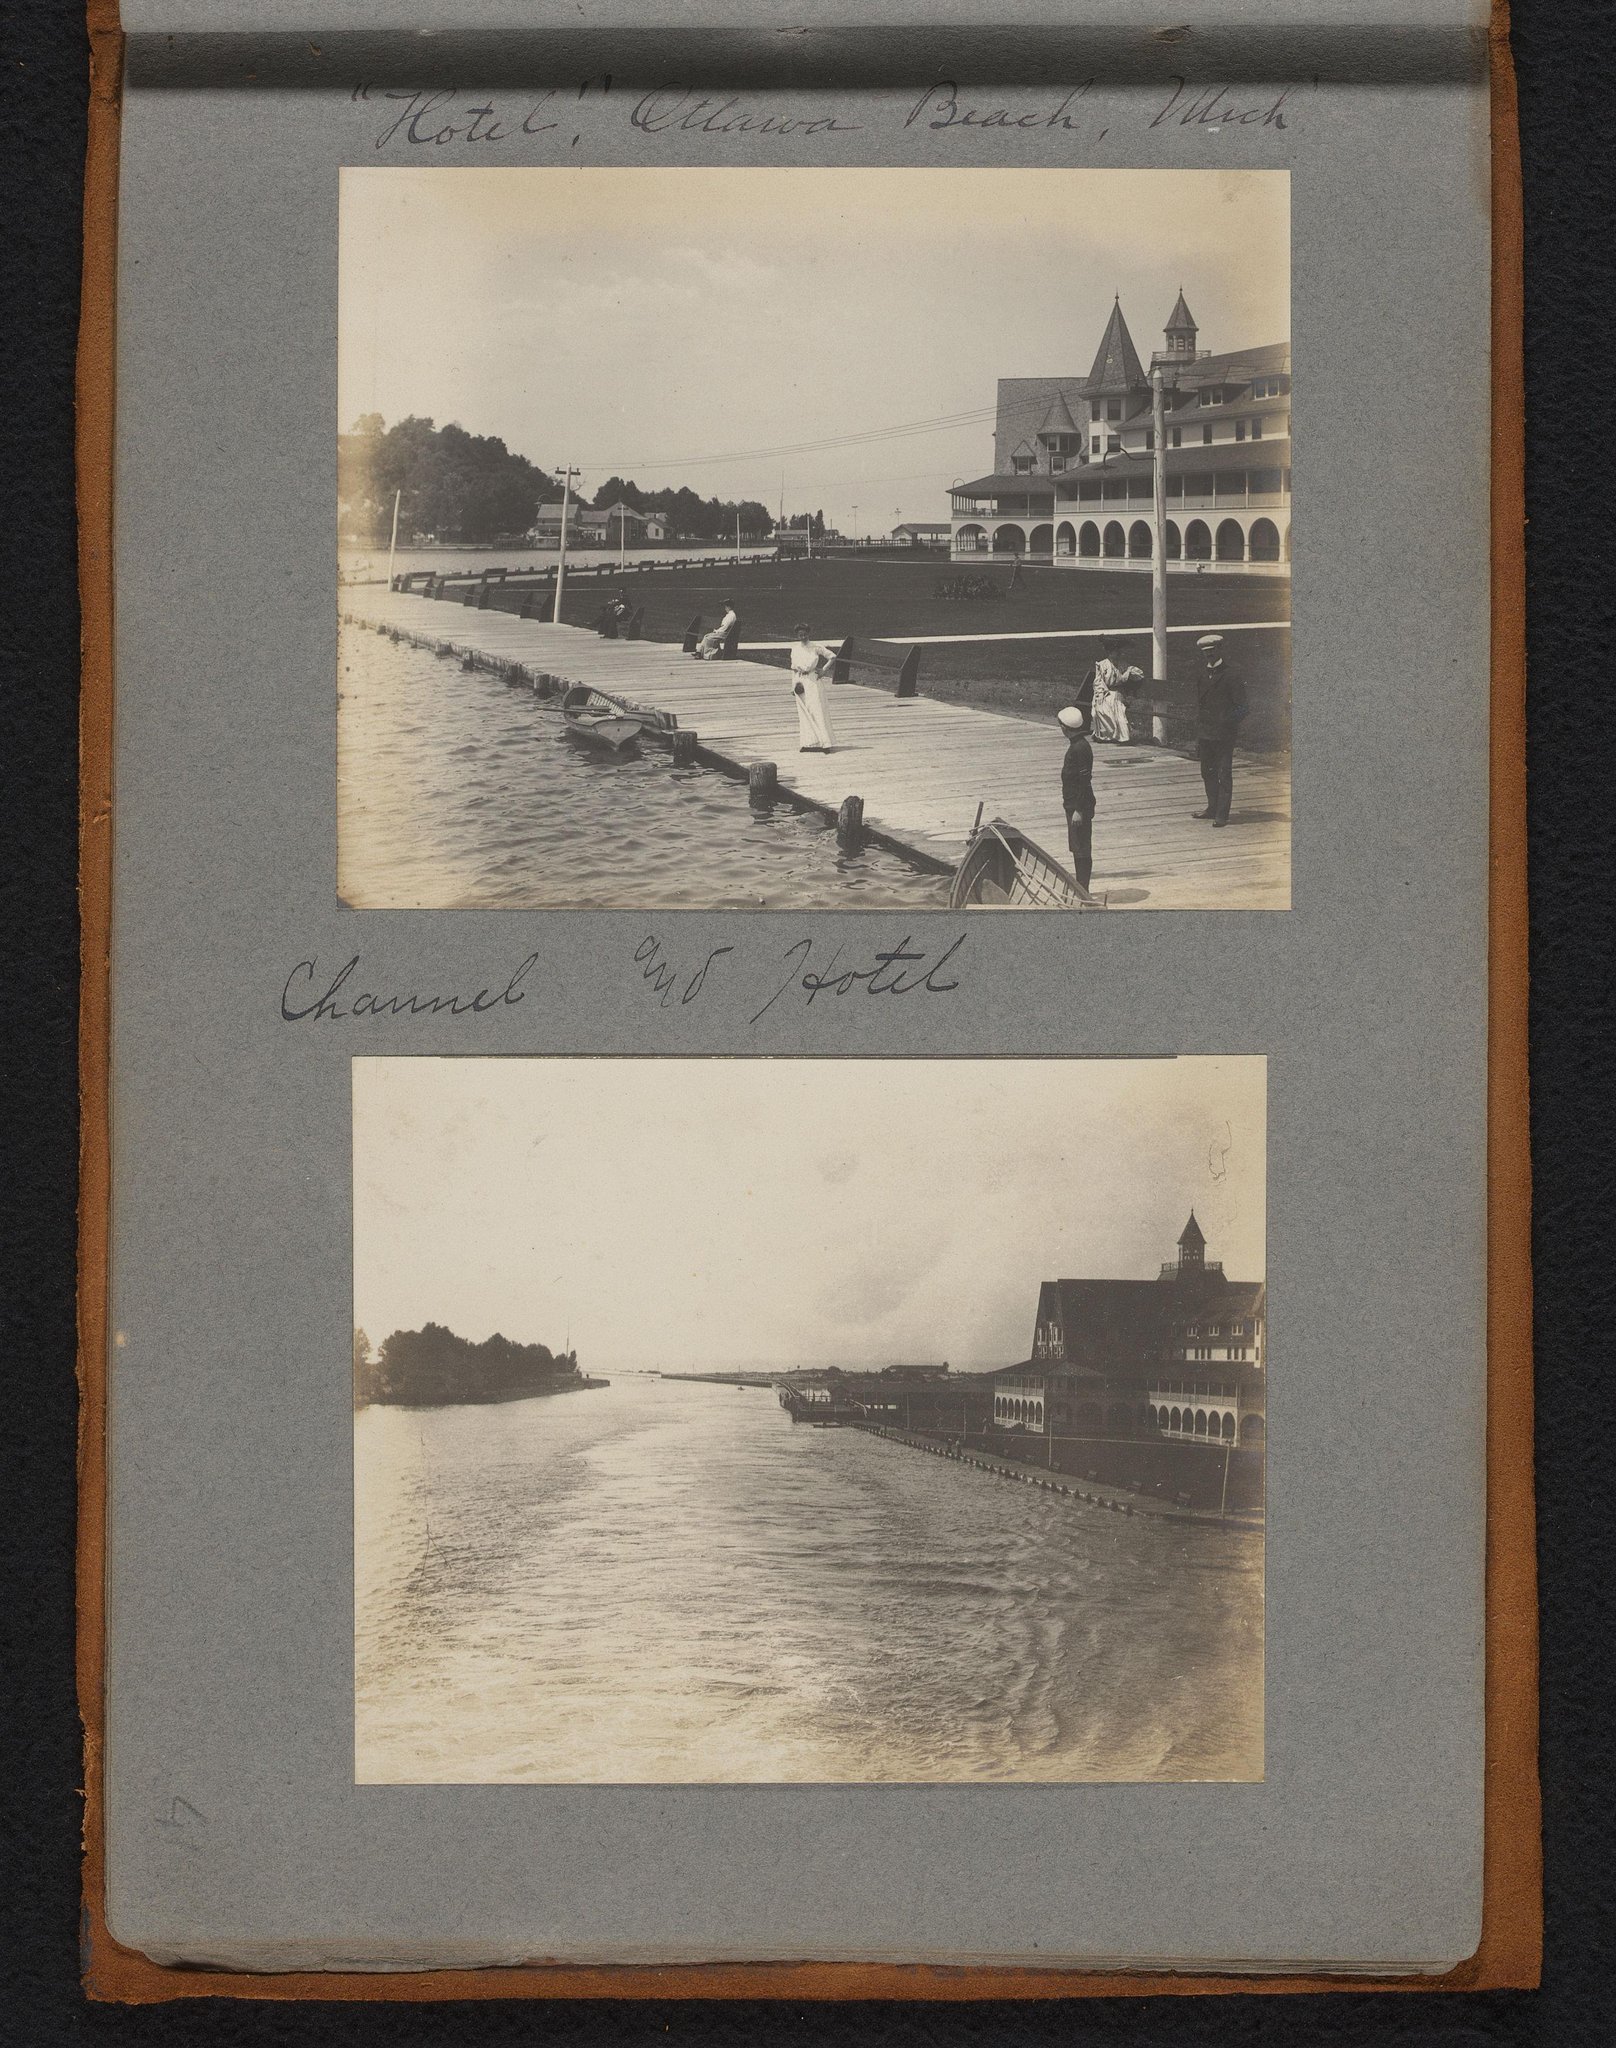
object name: album leaf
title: Gezicht op het voormalige Ottawa Beach Hotel aan het water in Michigan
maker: jan van der mey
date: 1902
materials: paper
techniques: gelatin silver print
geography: michigan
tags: canal, pier, quay, wharf, hotel, hostelry, inn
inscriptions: inscription: ‘"Hotel", Ottawa Beach, Mich./ Channel and Hotel’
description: Deze foto's maken deel uit van een album.